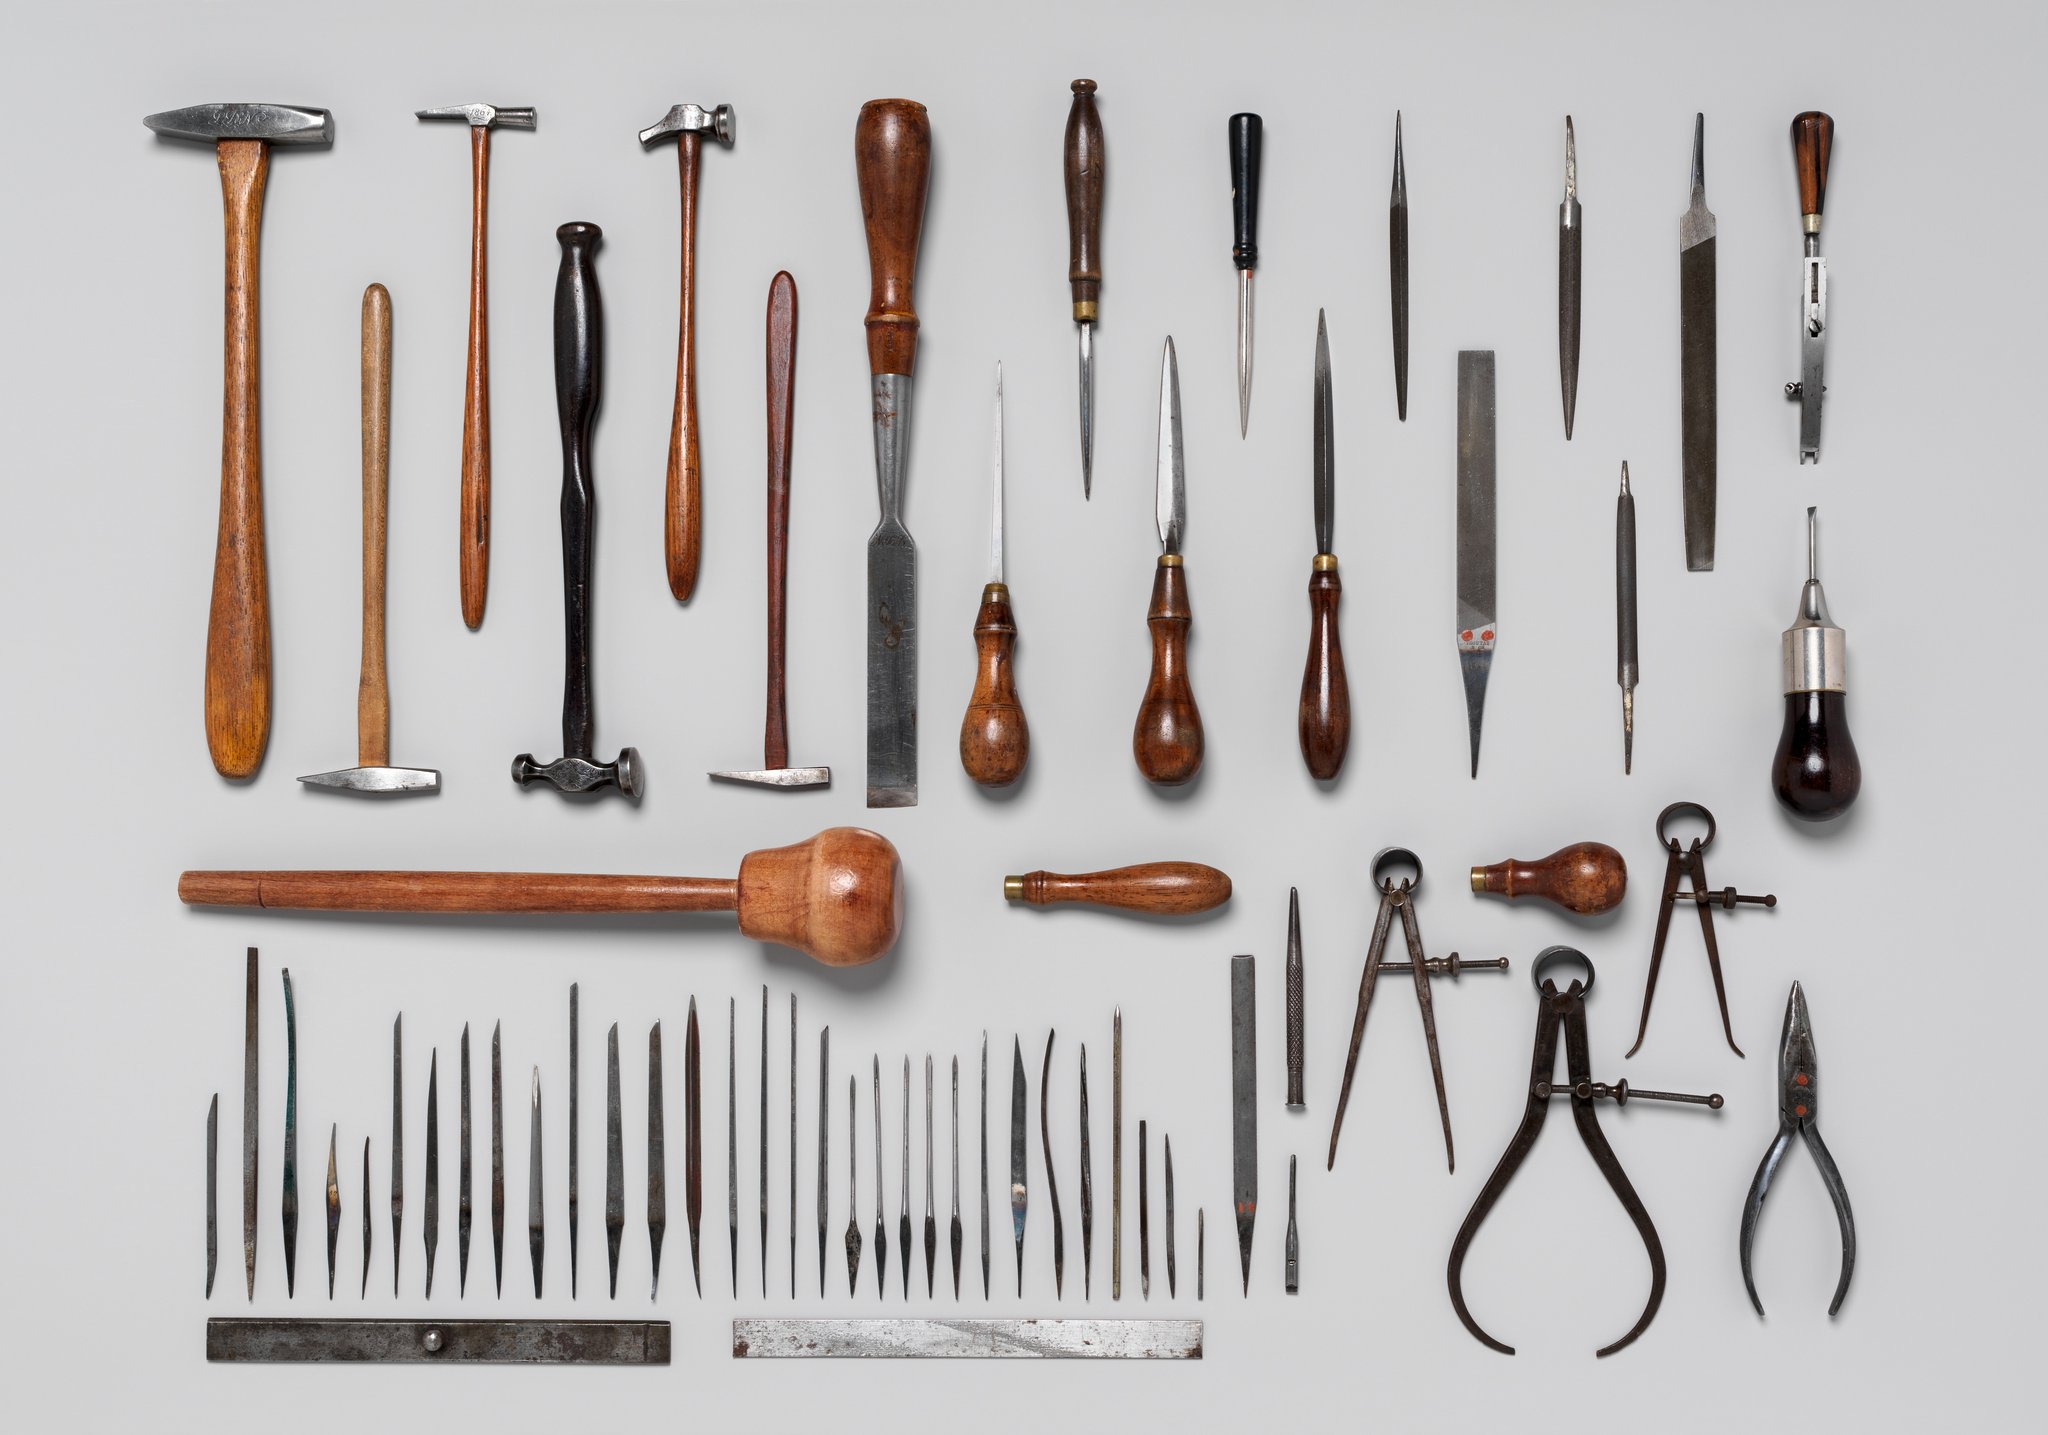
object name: tool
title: Set of Sixty-Two Engraving Tools of Louis D. Nimschke (1832–1904)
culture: american or european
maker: louis daniel nimschke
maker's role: engraver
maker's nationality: american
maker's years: 1825-1925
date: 1801-1900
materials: steel, wood